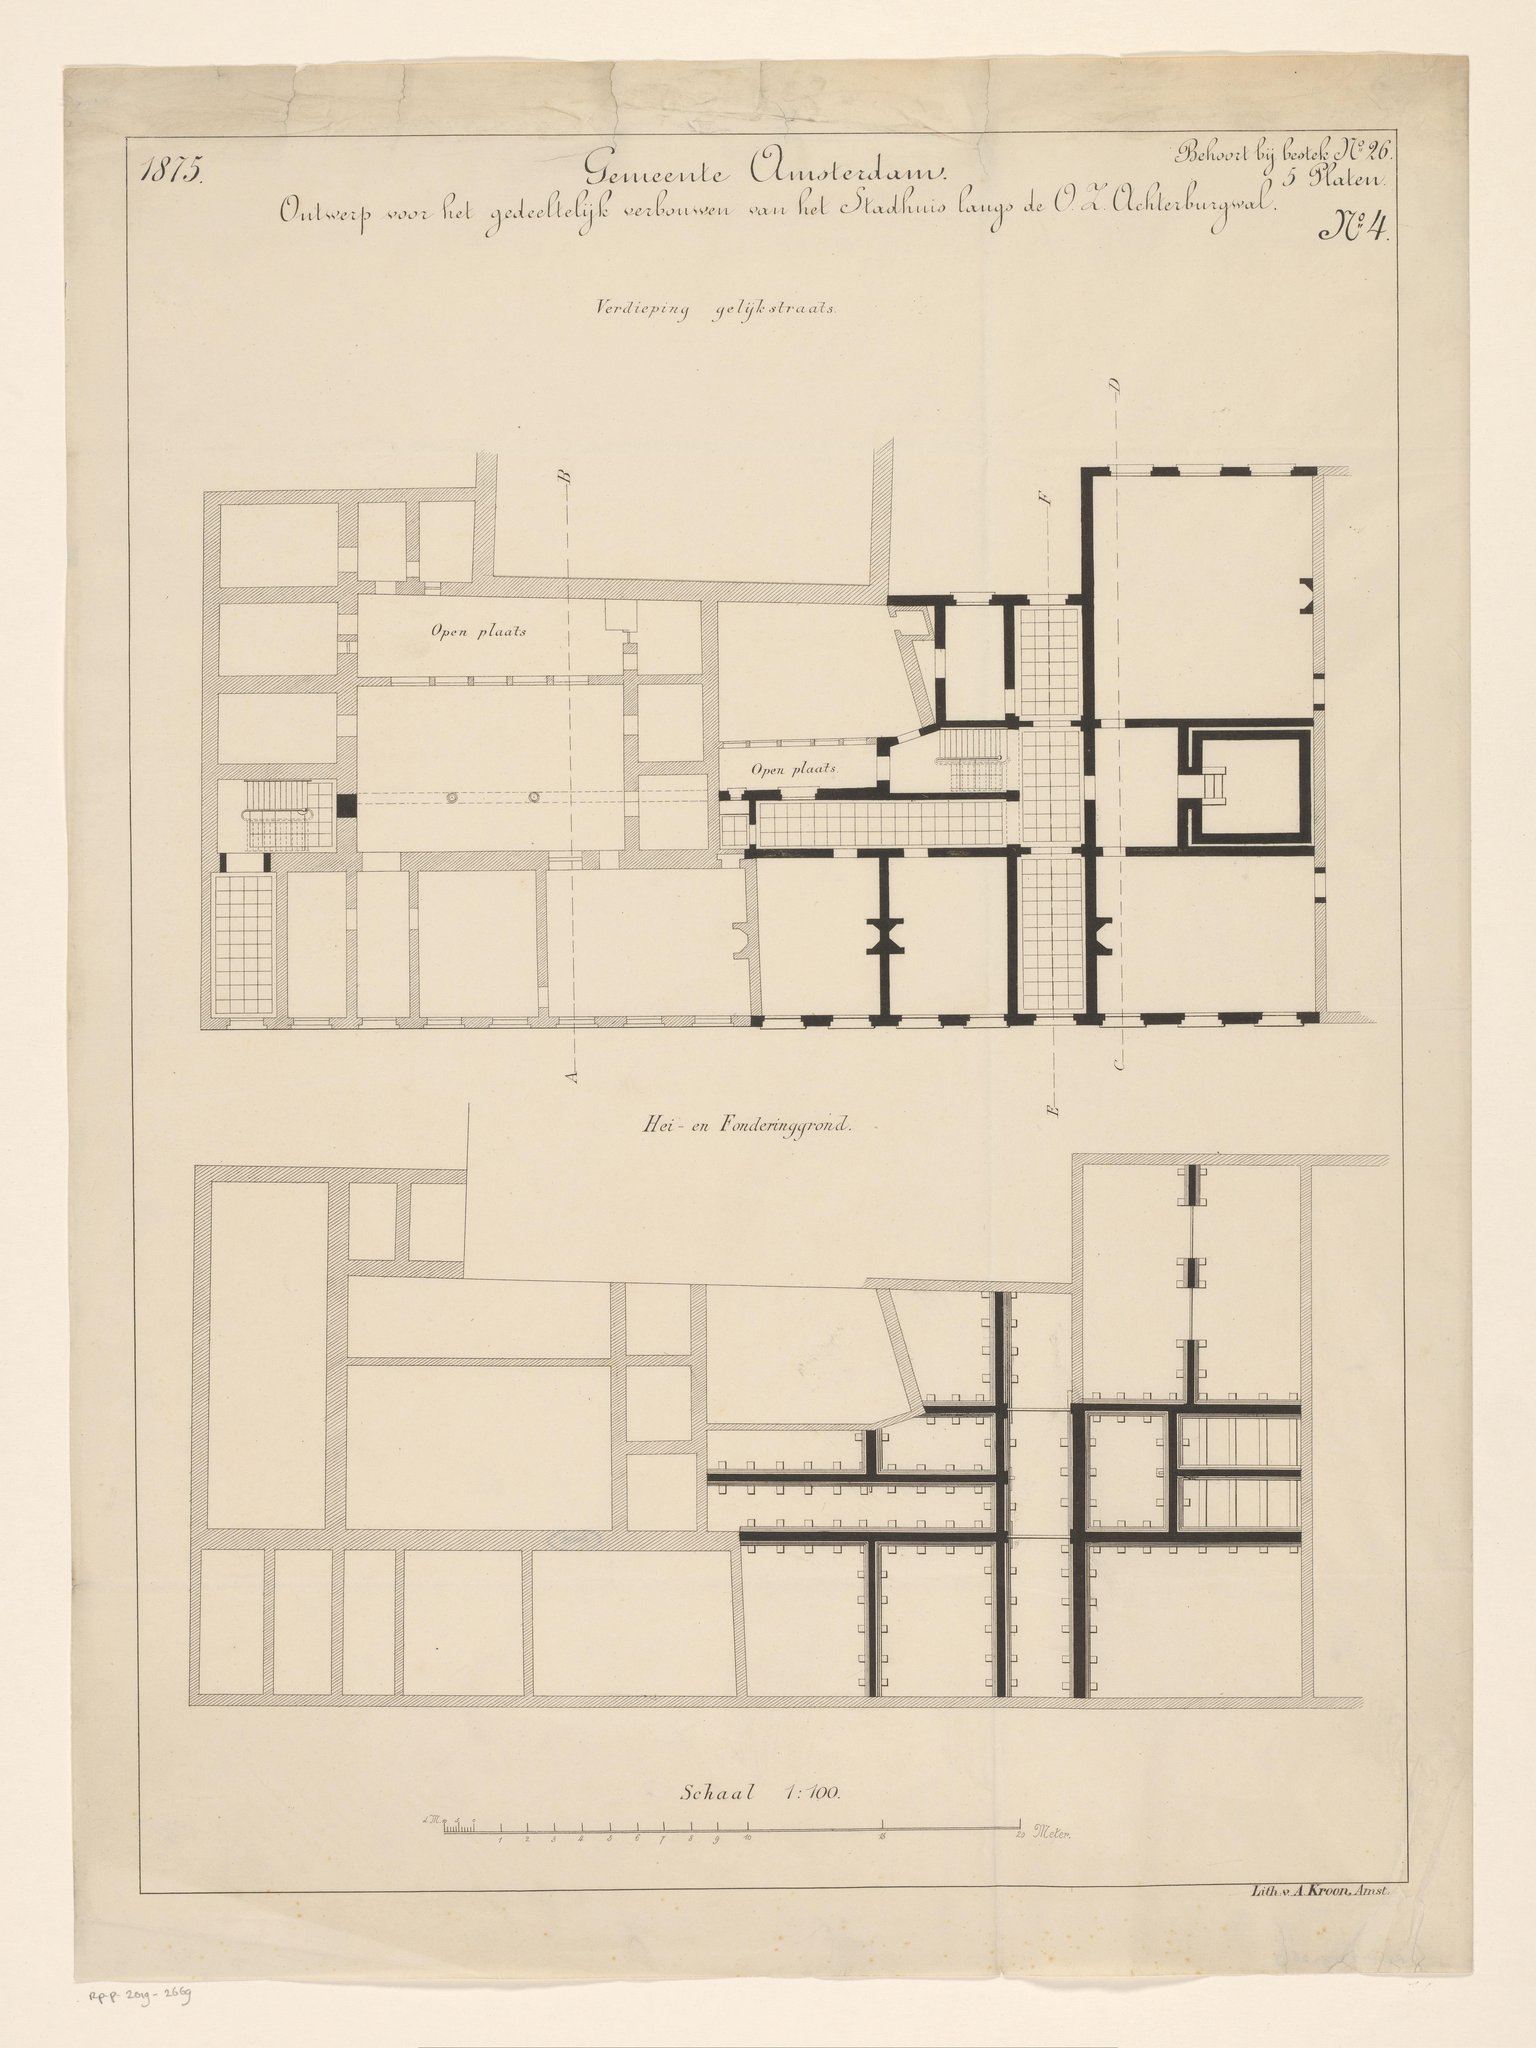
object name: area plan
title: Gemeente Amsterdam. Ontwerp voor het gedeeltelijk verbouwen van het Stadhuis langs de O.Z. Achterburgwal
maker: a. kroon (steendrukker)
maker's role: steendrukker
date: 1875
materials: paper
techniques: lithograph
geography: amsterdam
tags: maps, atlases, townhall, architectural design or model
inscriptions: collector's mark: Lugt 2228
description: Plattegrond van de begane grond en de fundering van het Stadhuis te Amsterdam.